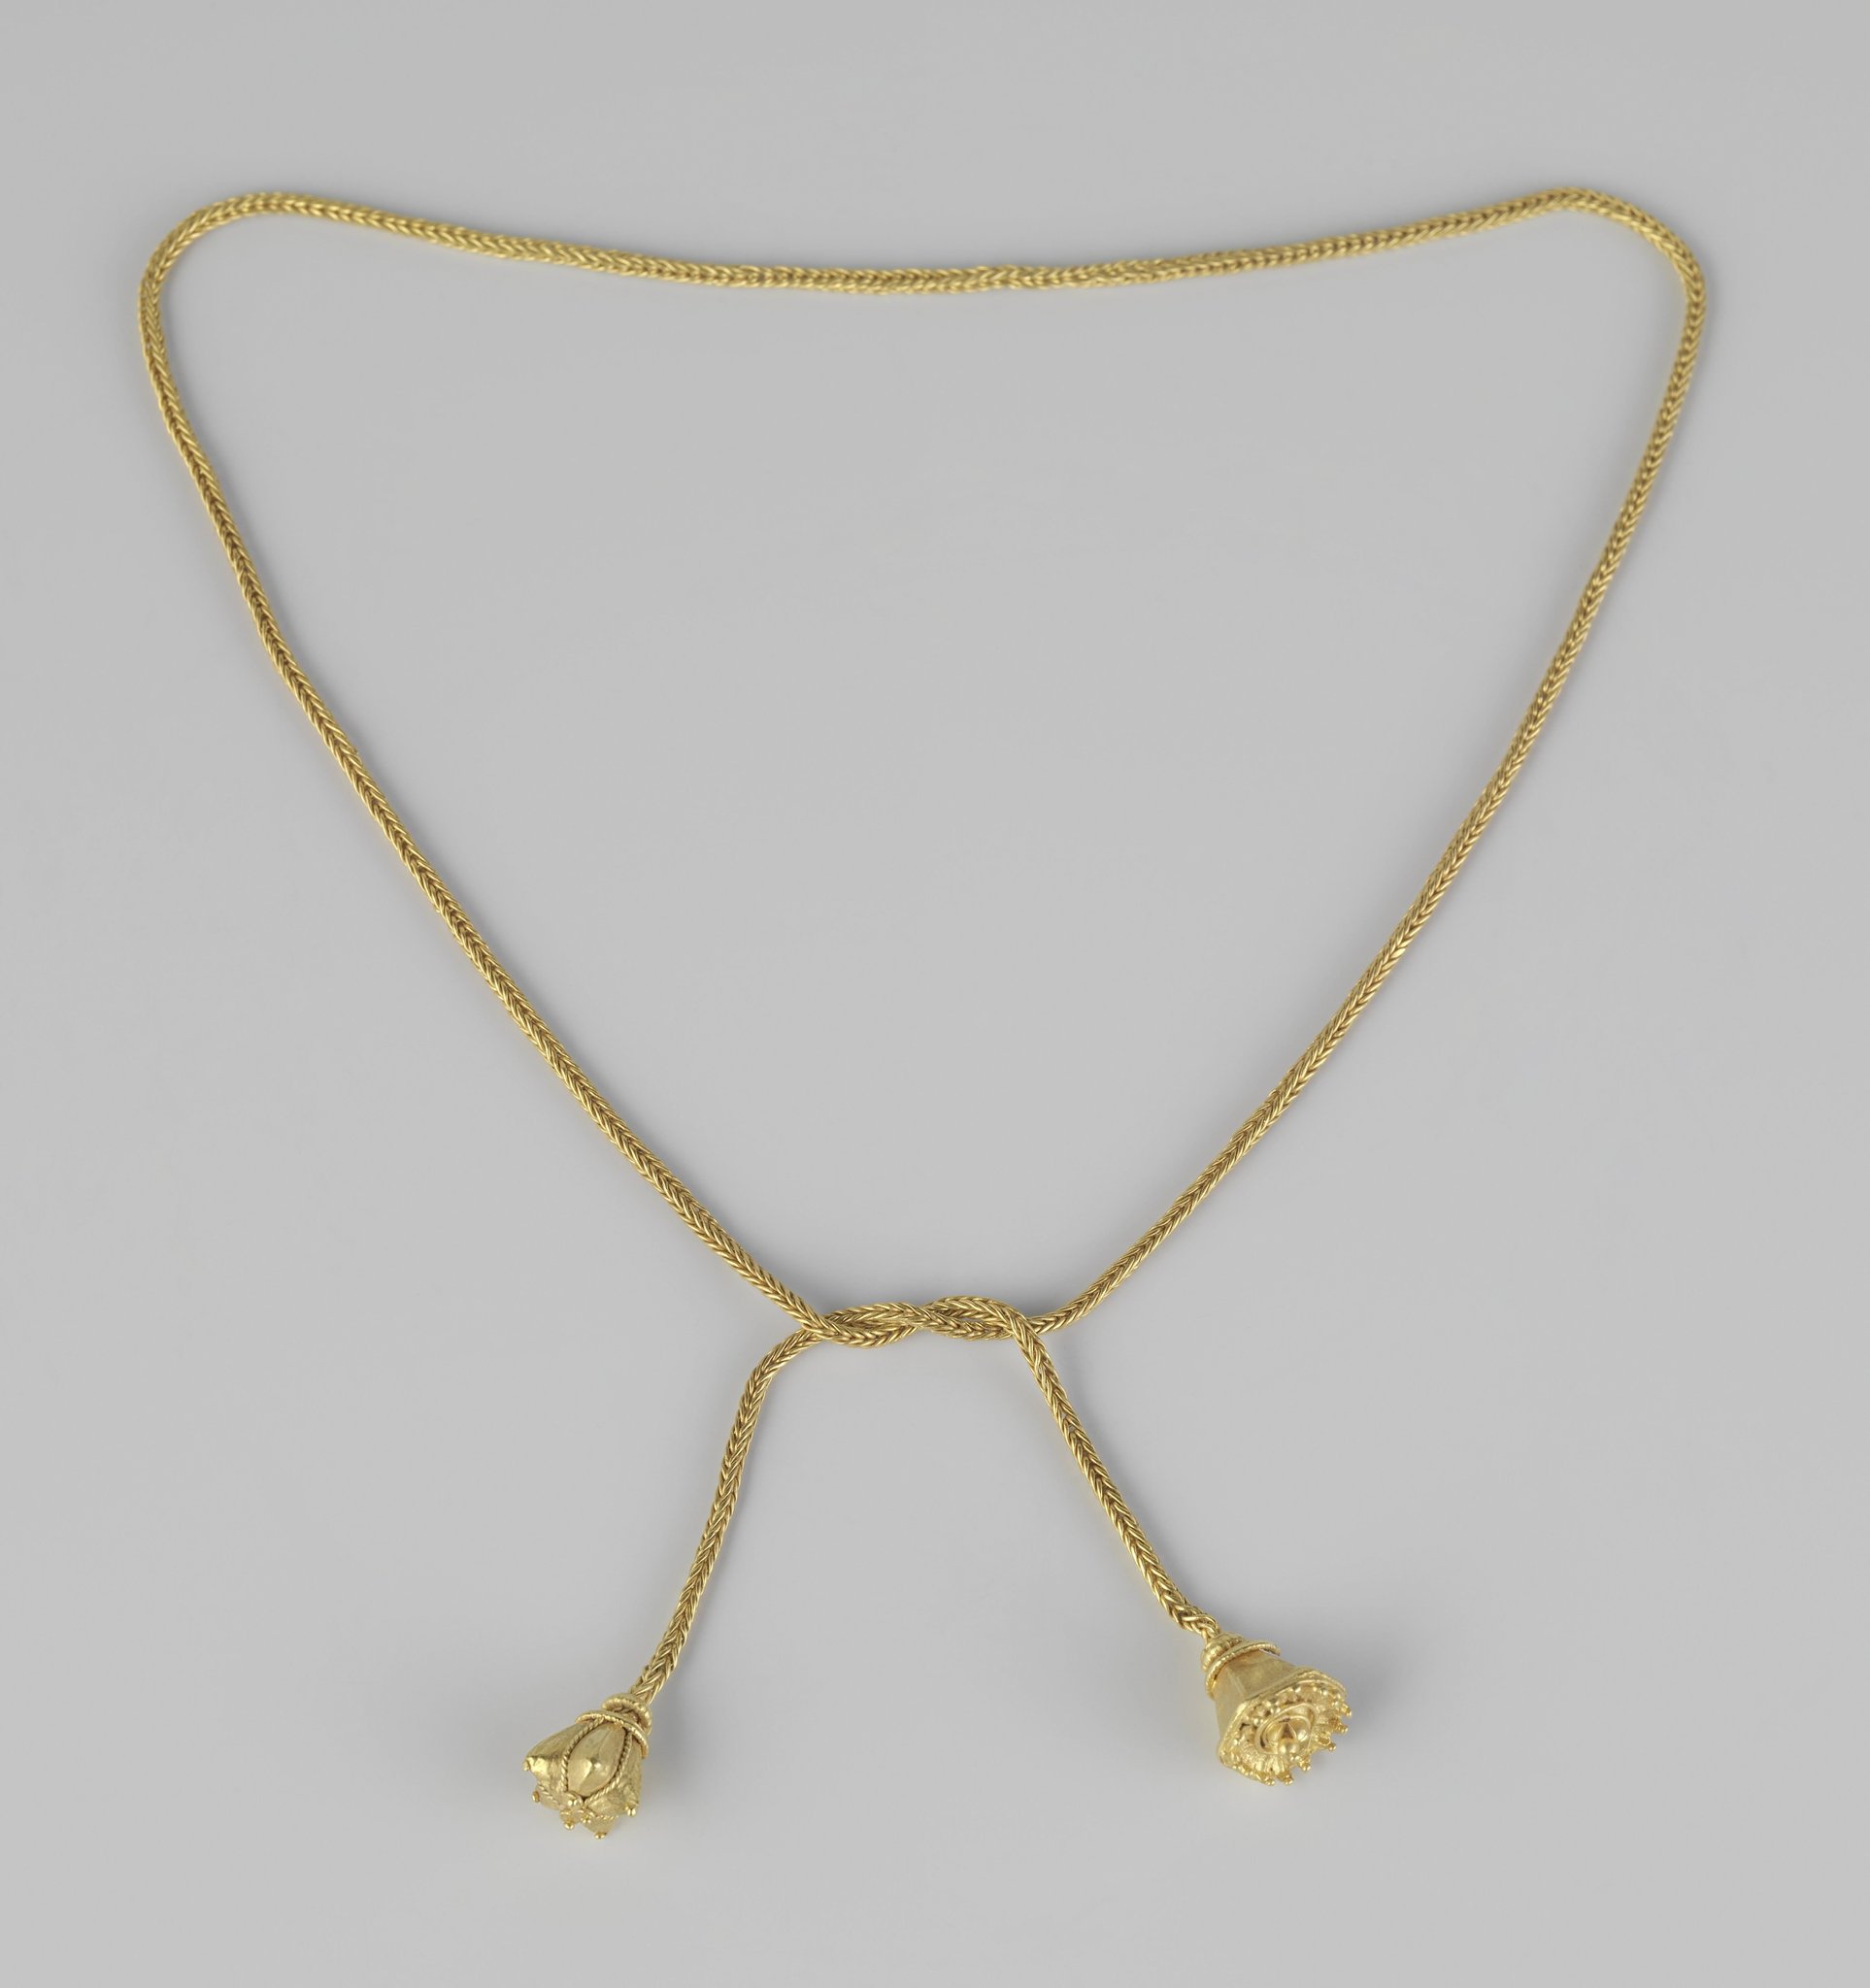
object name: necklace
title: Decorative Chain with Terminals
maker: Anonymous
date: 800-1000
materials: gold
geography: indonesia